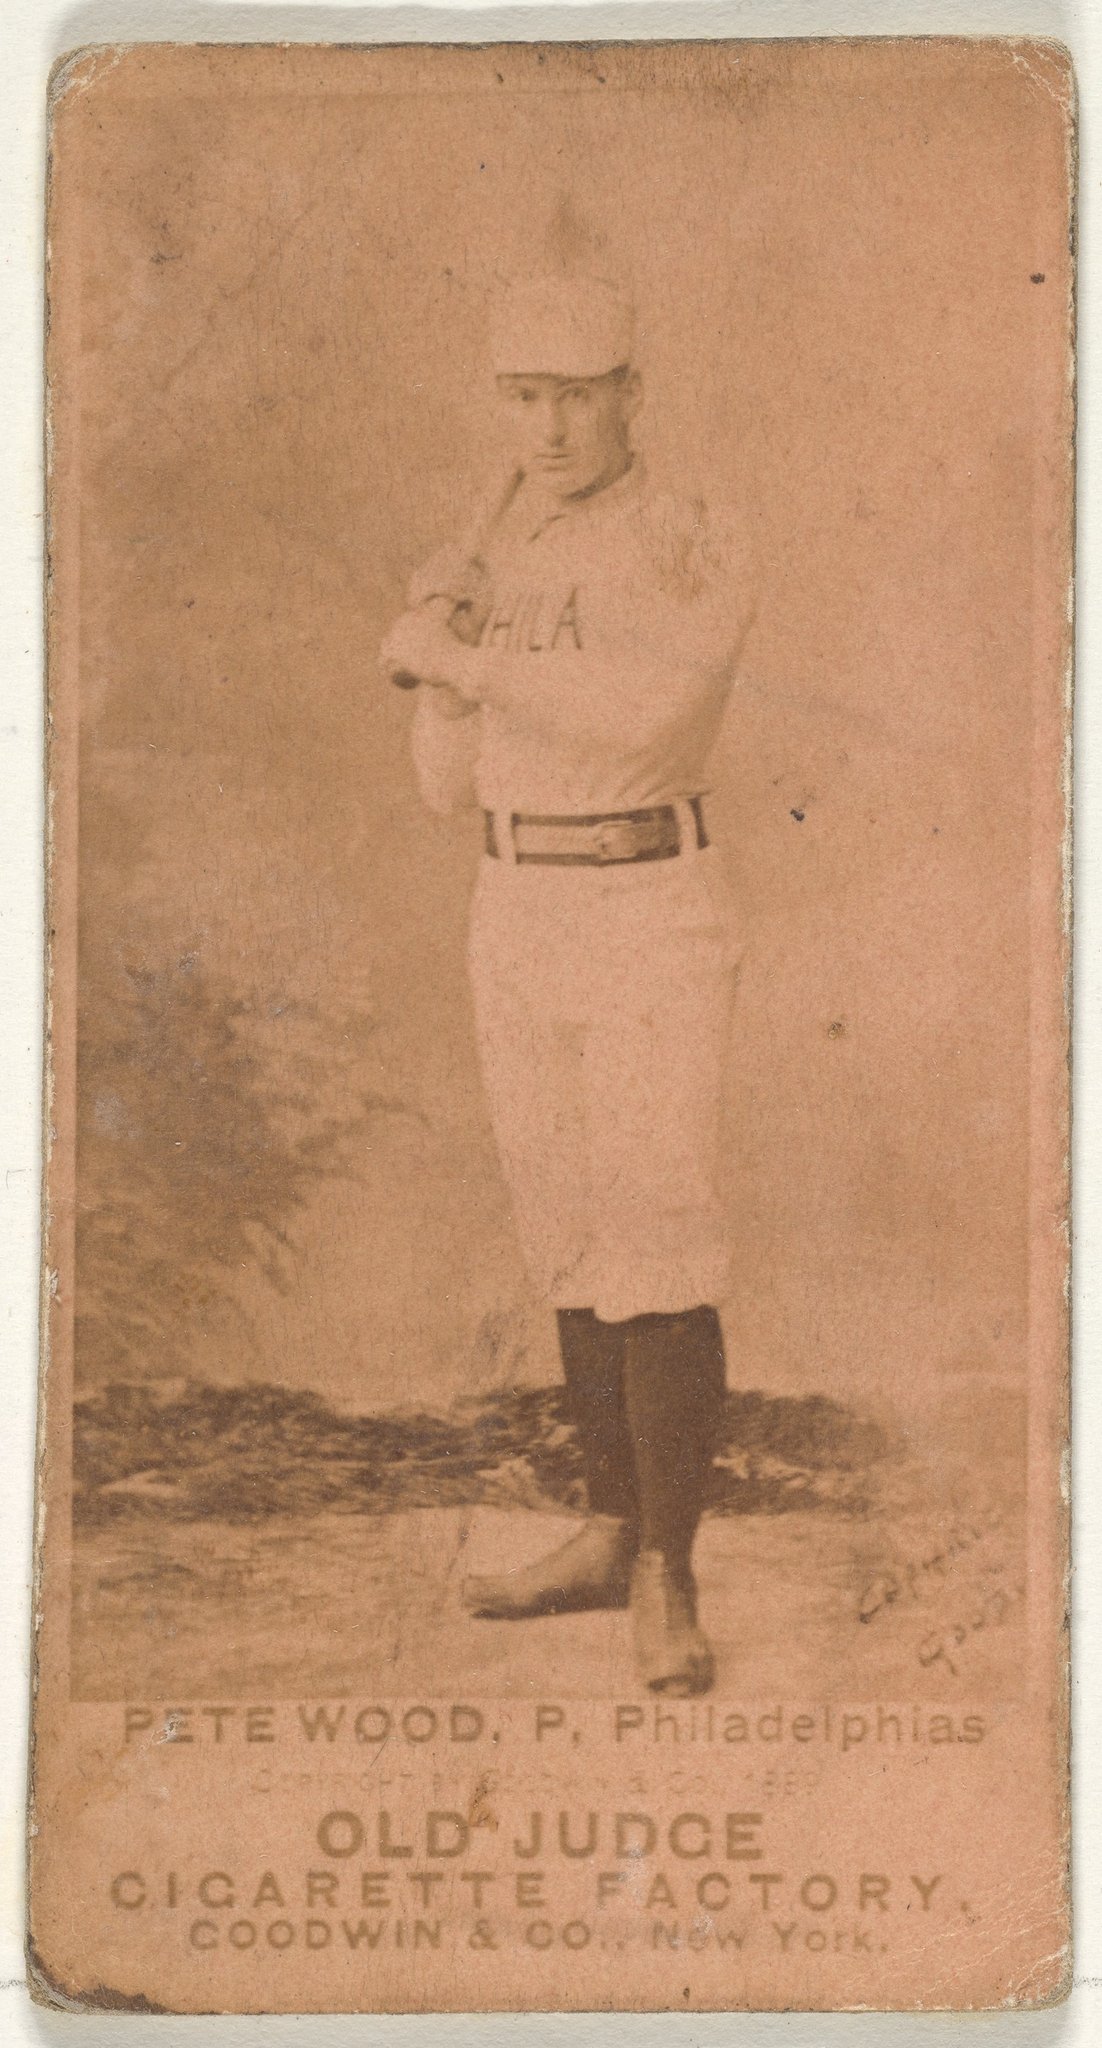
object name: baseball card, photograph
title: Peter Burke "Pete" Wood, Pitcher, Philadelphia, from the Old Judge series (N172) for Old Judge Cigarettes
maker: goodwin & company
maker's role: publisher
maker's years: 1850-1950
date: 1887-1890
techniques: albumen silver print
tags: men,portraits,baseball,athletes